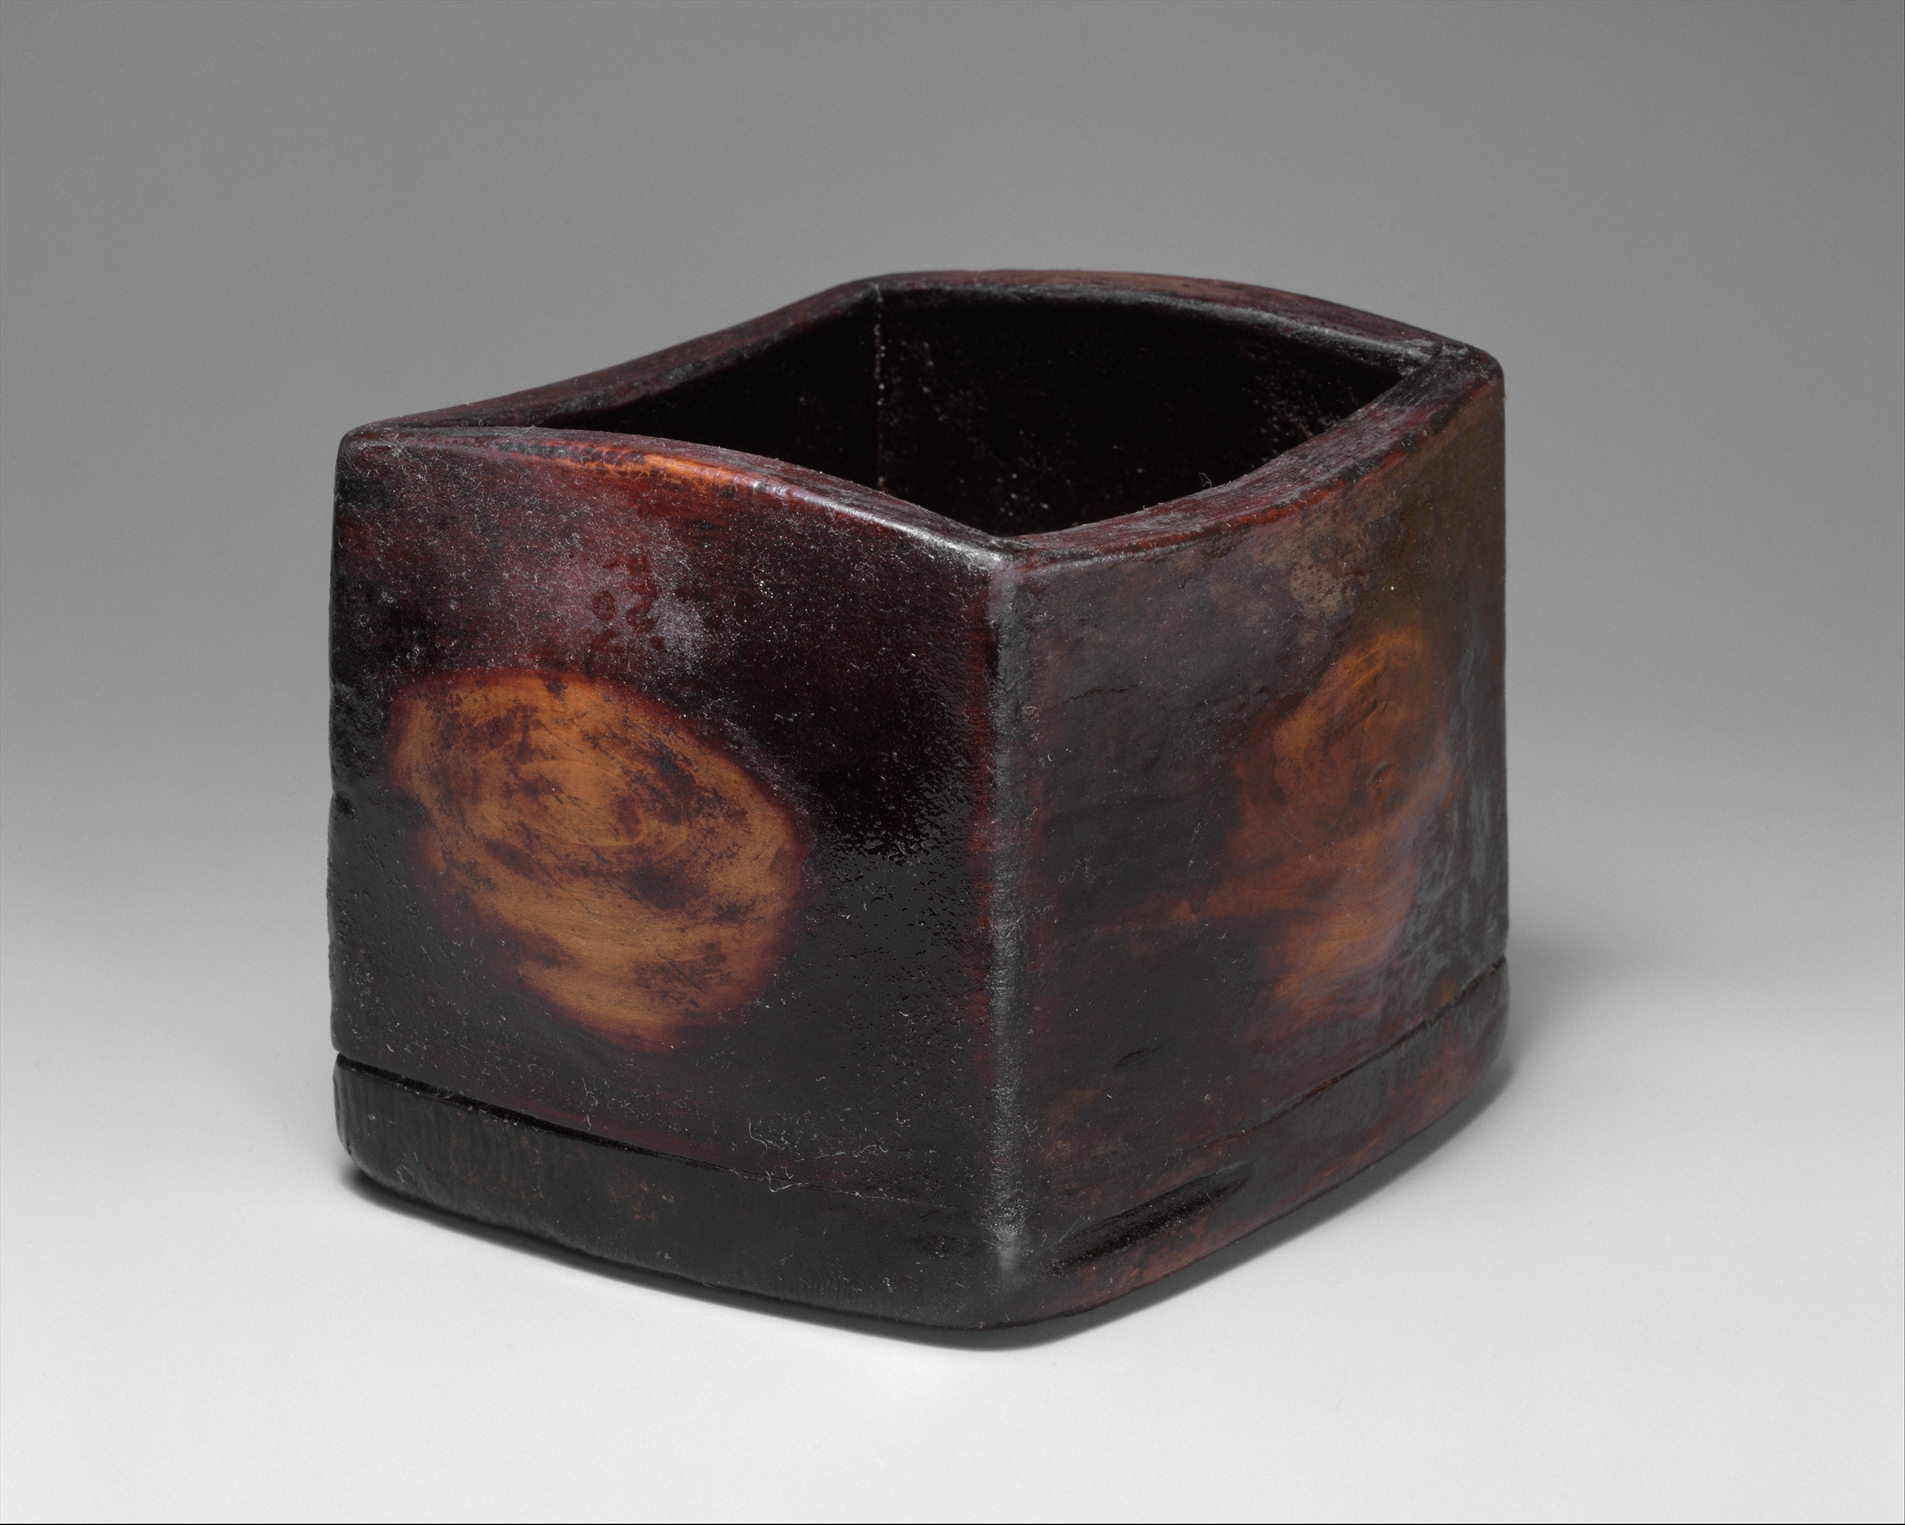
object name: bowl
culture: haida or tlingit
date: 1801-1833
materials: wood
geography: united states